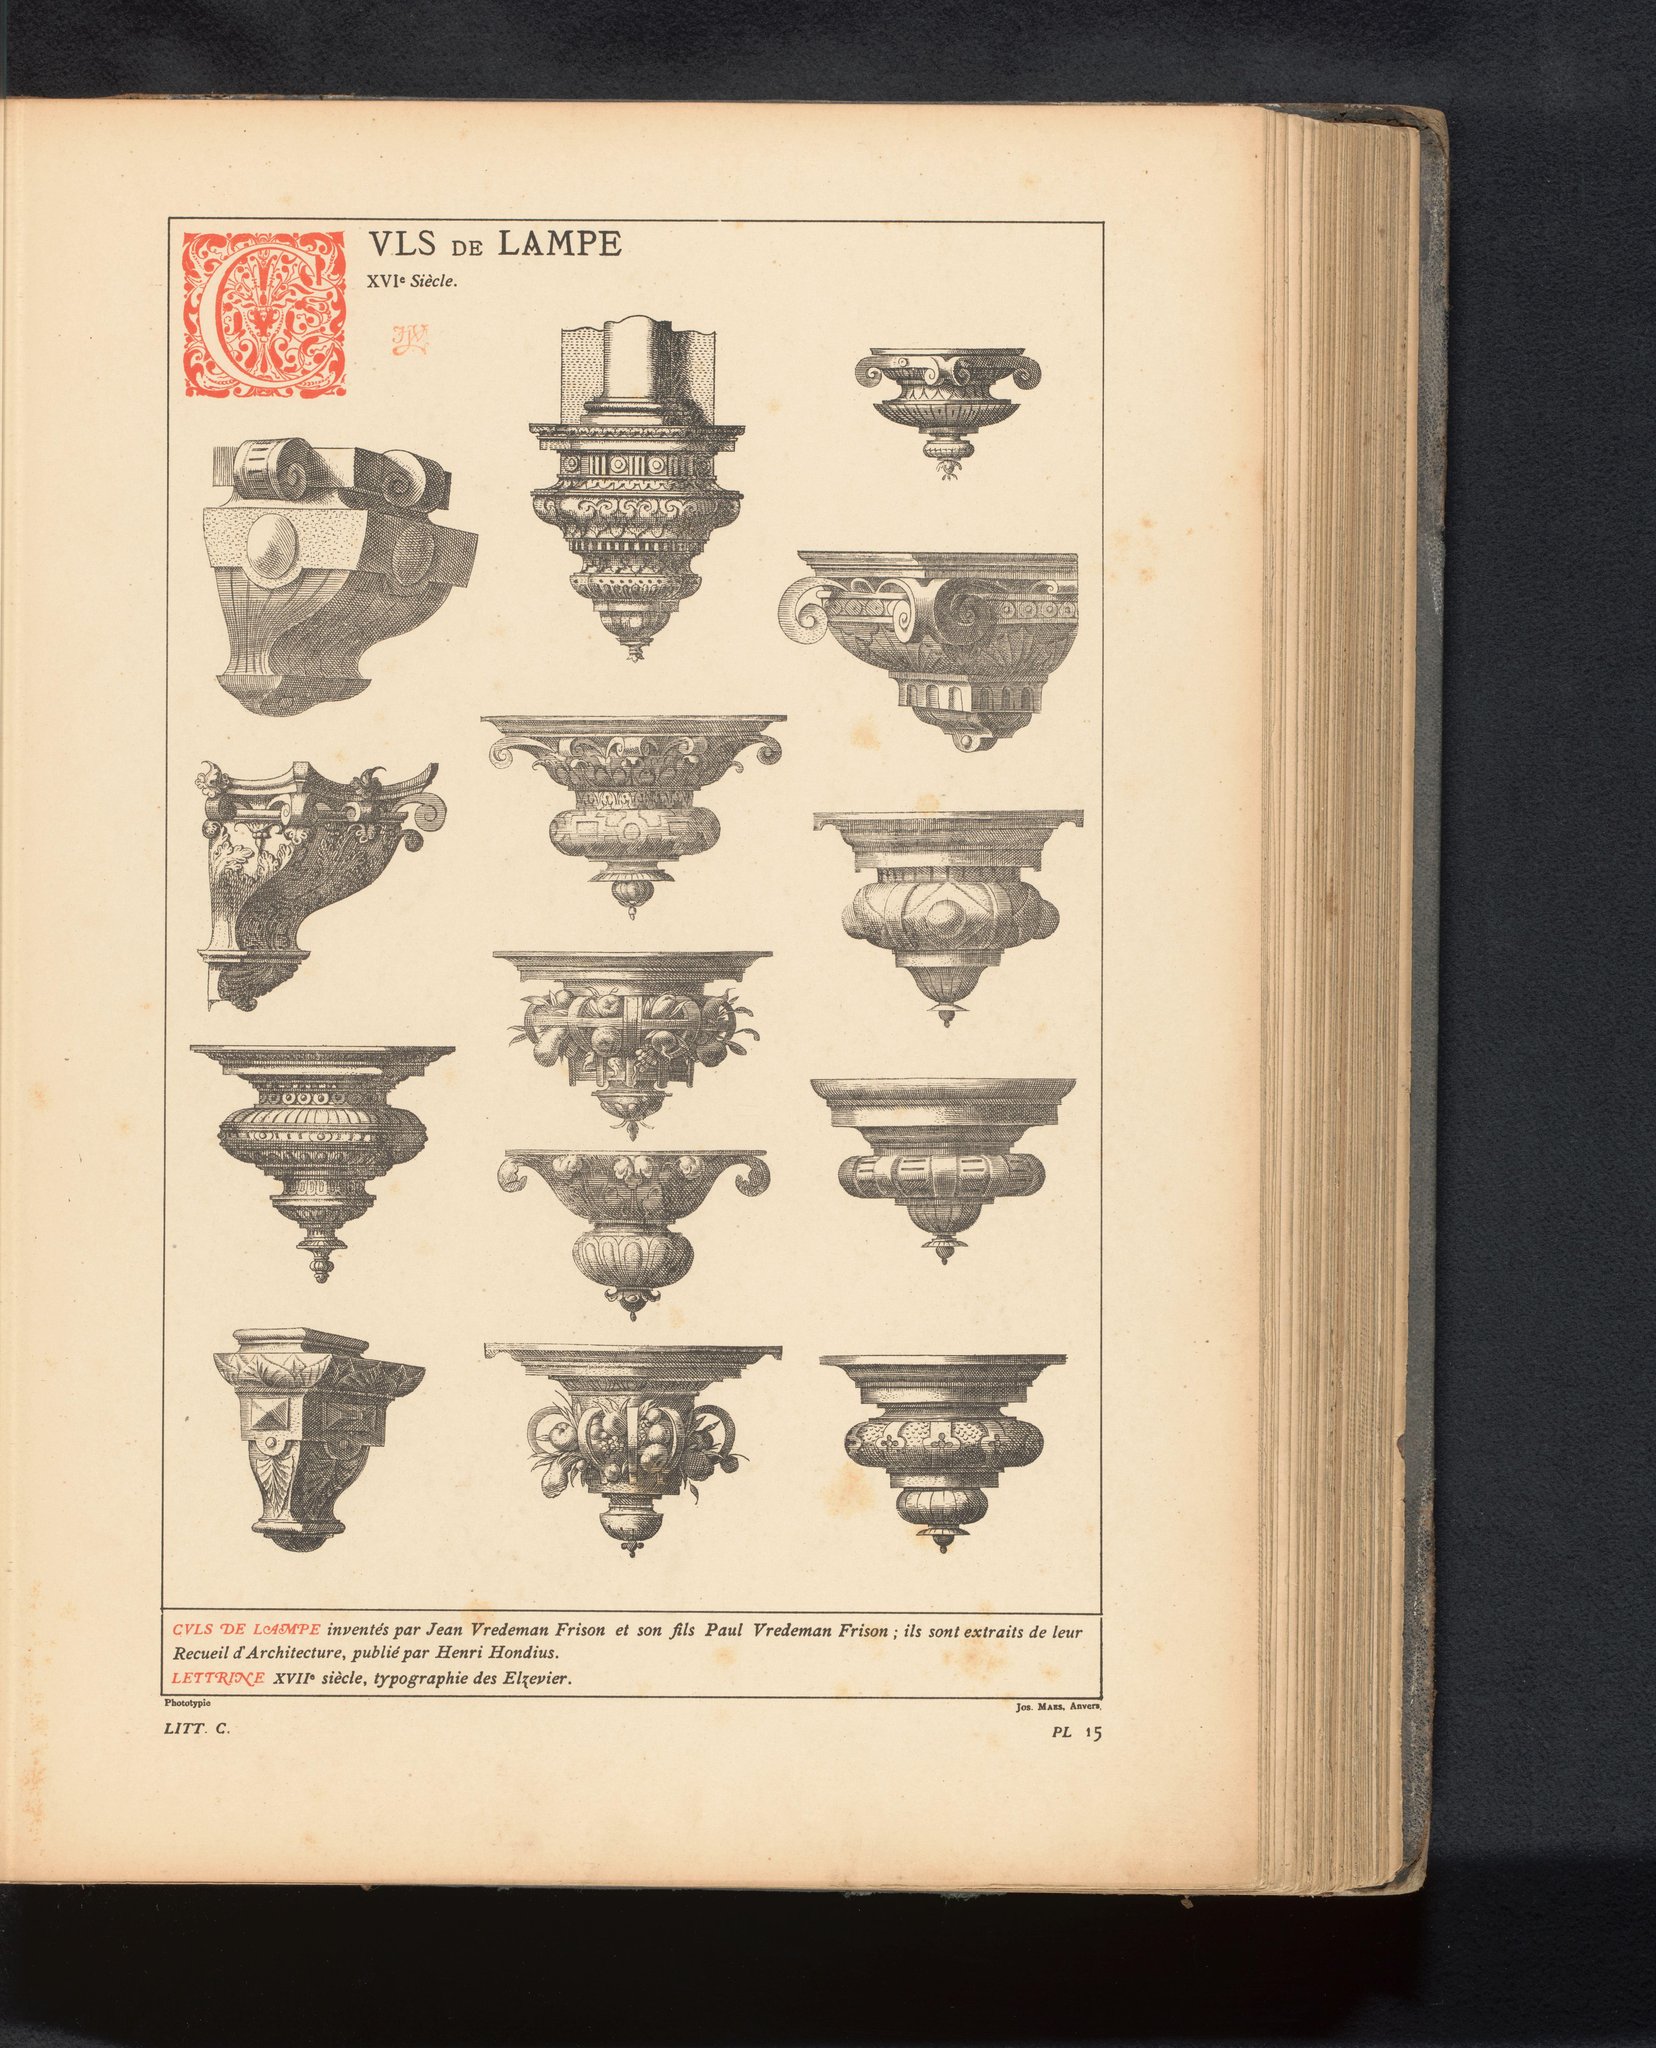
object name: page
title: Reproductie van een ontwerp met veertien consoles en kraagstenen door Paul en Hans Vredeman de Vries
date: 1875-1880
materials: paper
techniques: photolithography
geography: antwerp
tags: emperor, clothes, costume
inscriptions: inscription: ‘Culs de lampe (...)’, inscription: ‘LITT: C. - PL. 15’, monogram: ‘JJvY’